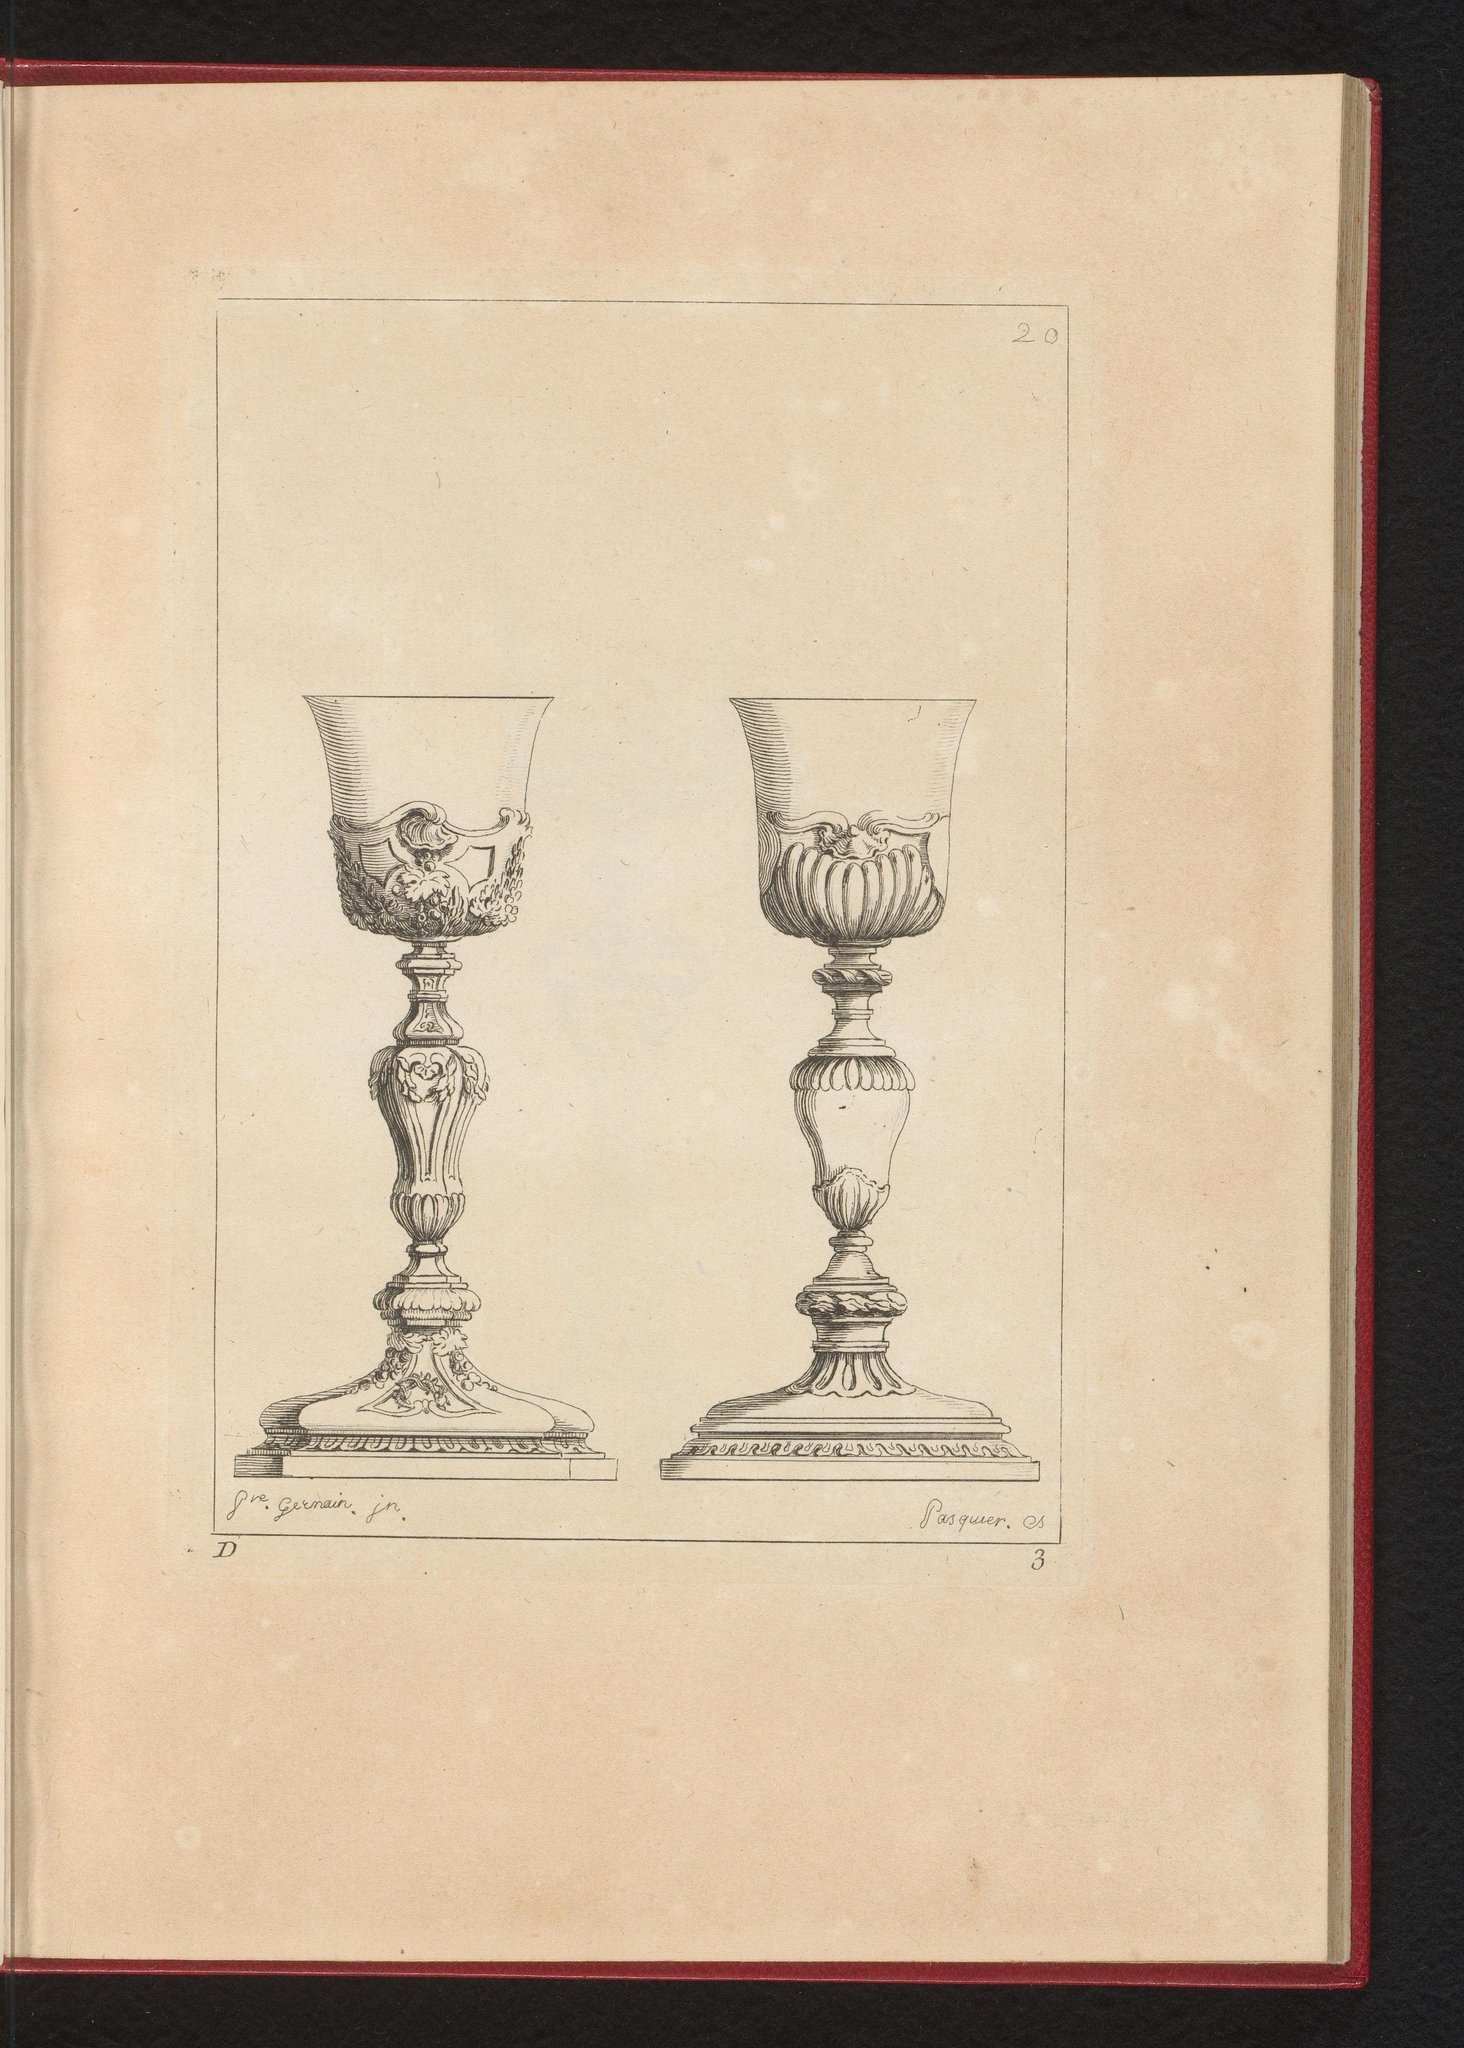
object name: print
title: Ontwerpen voor liturgische wijnbekers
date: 1748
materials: paper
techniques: etching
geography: paris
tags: chalice, jeweller, goldsmith, silversmith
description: Een aantal van de objecten in deze reeks heeft een eigen ondertitel, die verwijst naar genummerde 'cahiers' (afleveringen) waarin de prenten werden uitgegeven. Het is onduidelijk welke objecten recies bij welke aflevering horen. Daarom is die ondertitel enkel verwerkt bij de prent waarop die voorkomt.